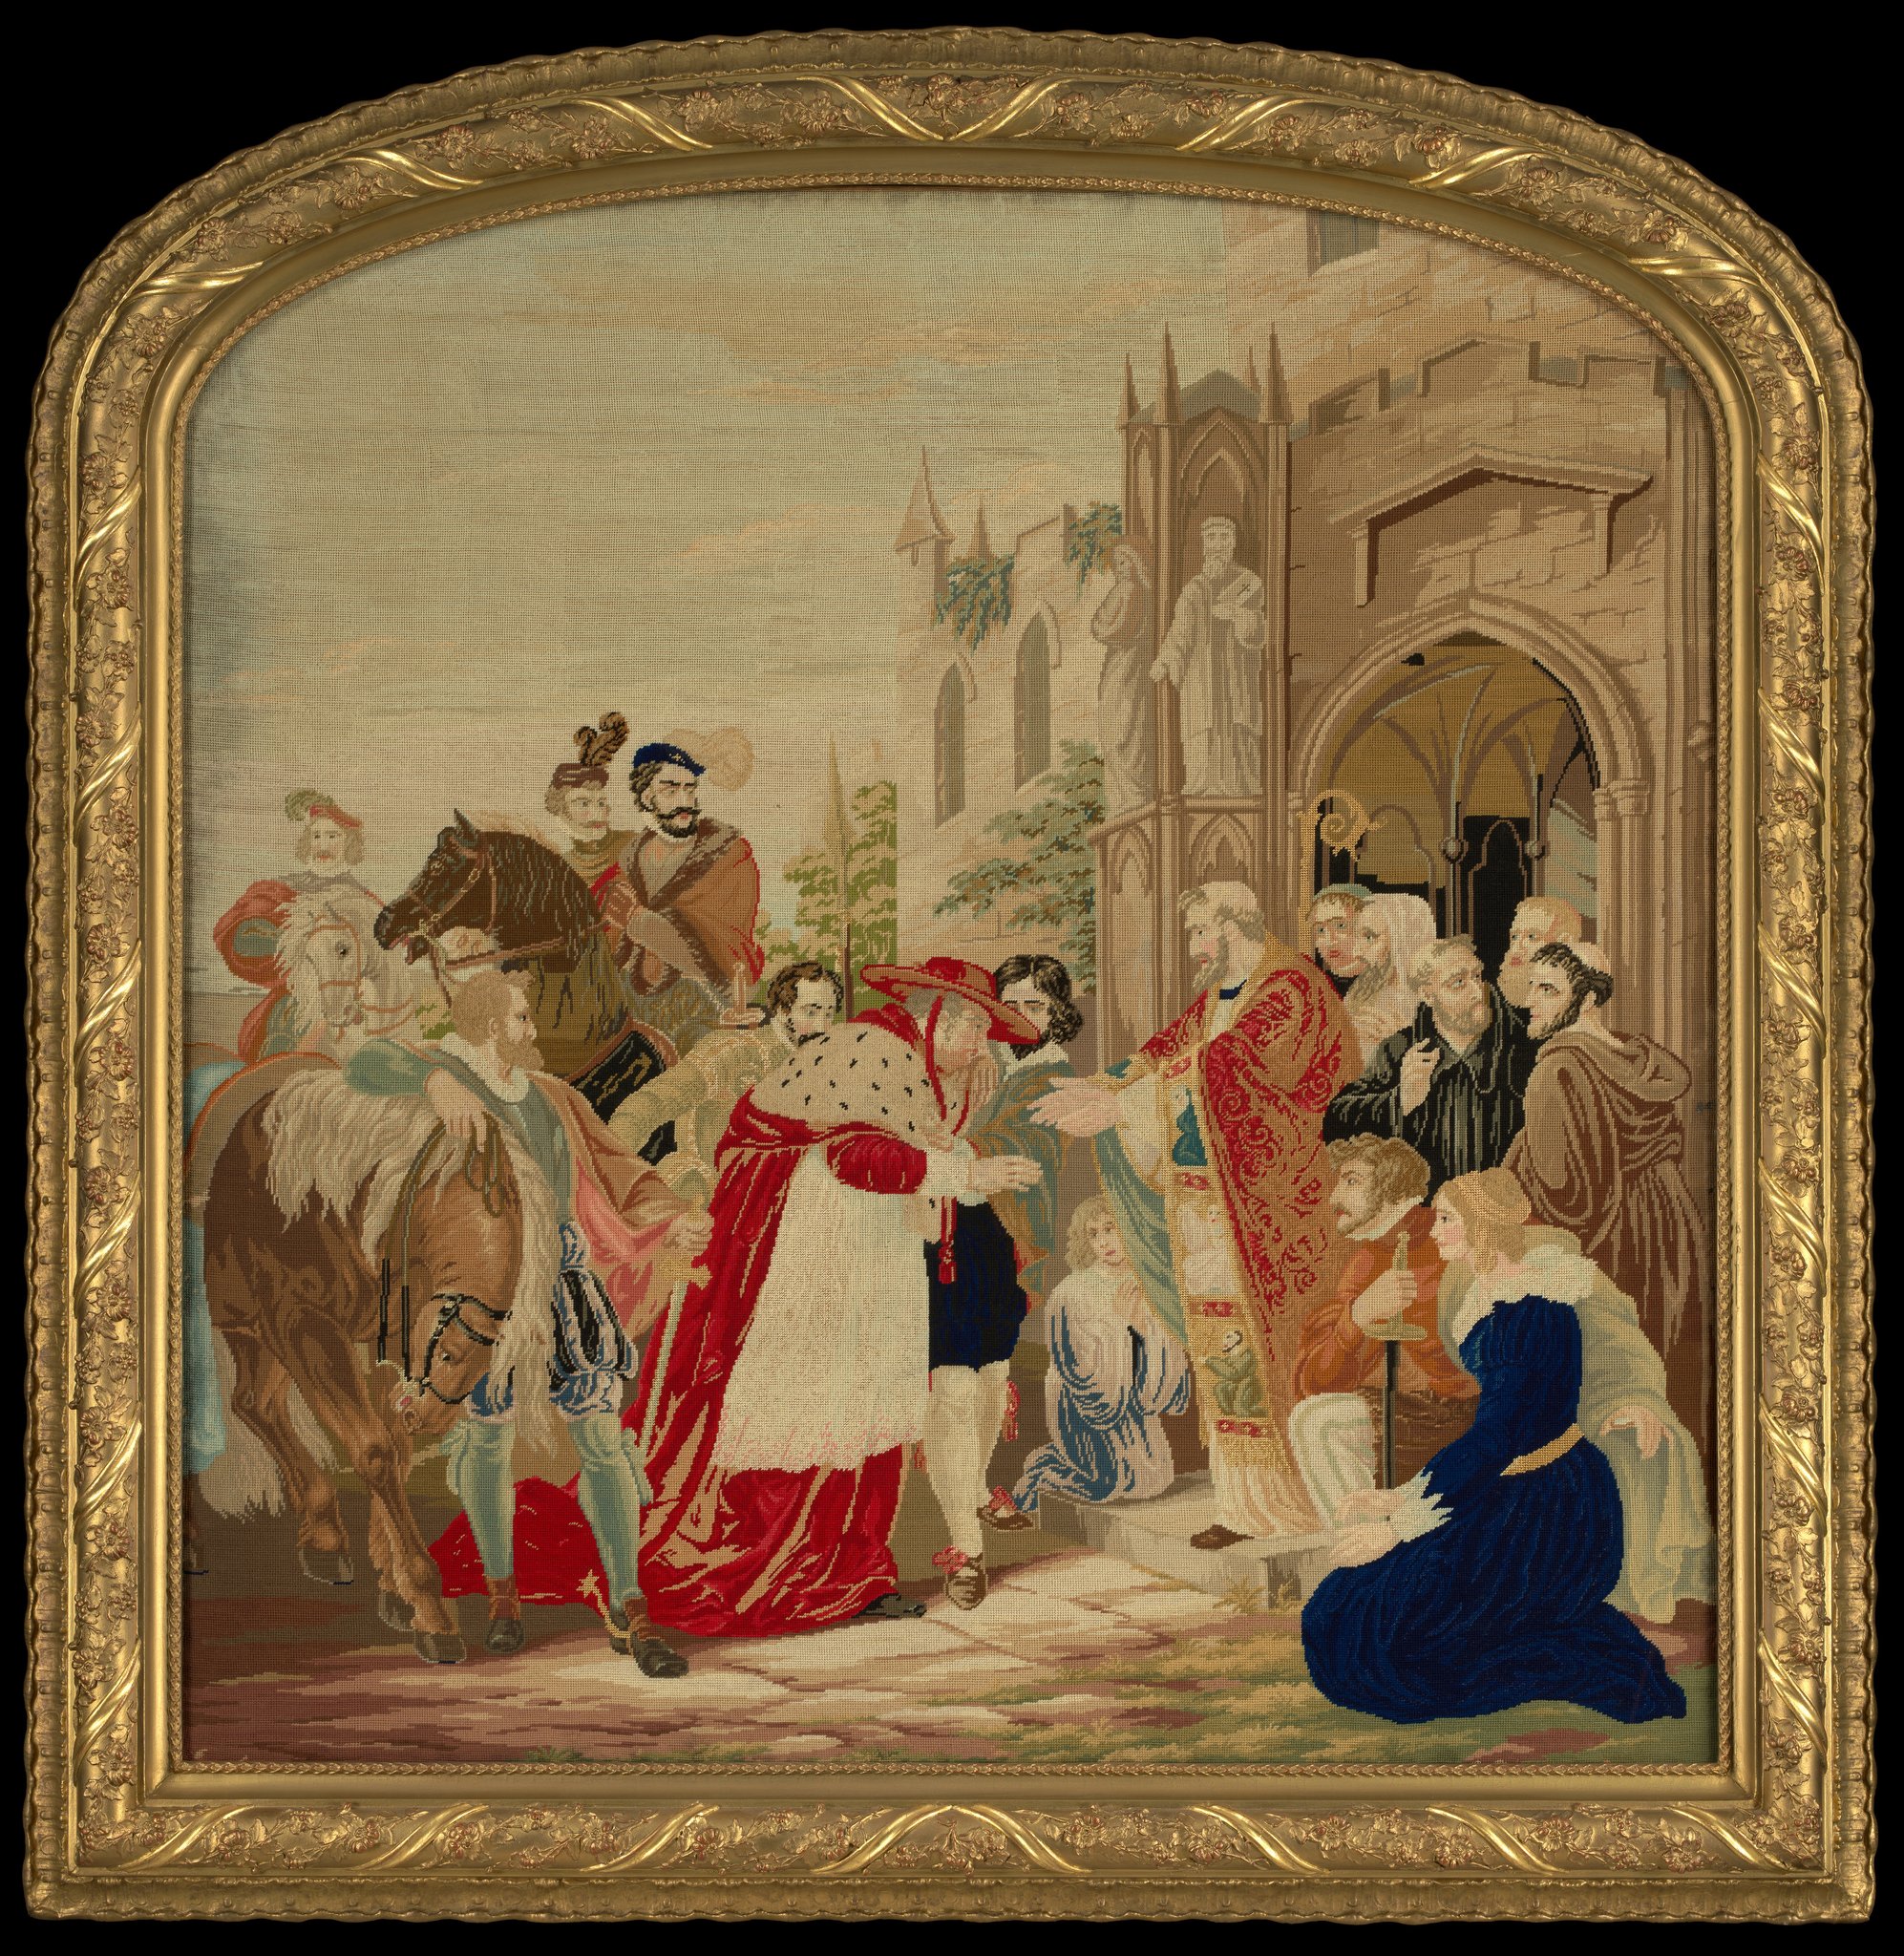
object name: needlework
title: Needlework picture of scene from Shakespeare’s "Henry VIII"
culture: american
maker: agnes (pruyn) strain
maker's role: artist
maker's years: 1839-1898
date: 1865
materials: canvas, linen, silk, wool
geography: albany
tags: henry viii,shakespeare,men,women,horses